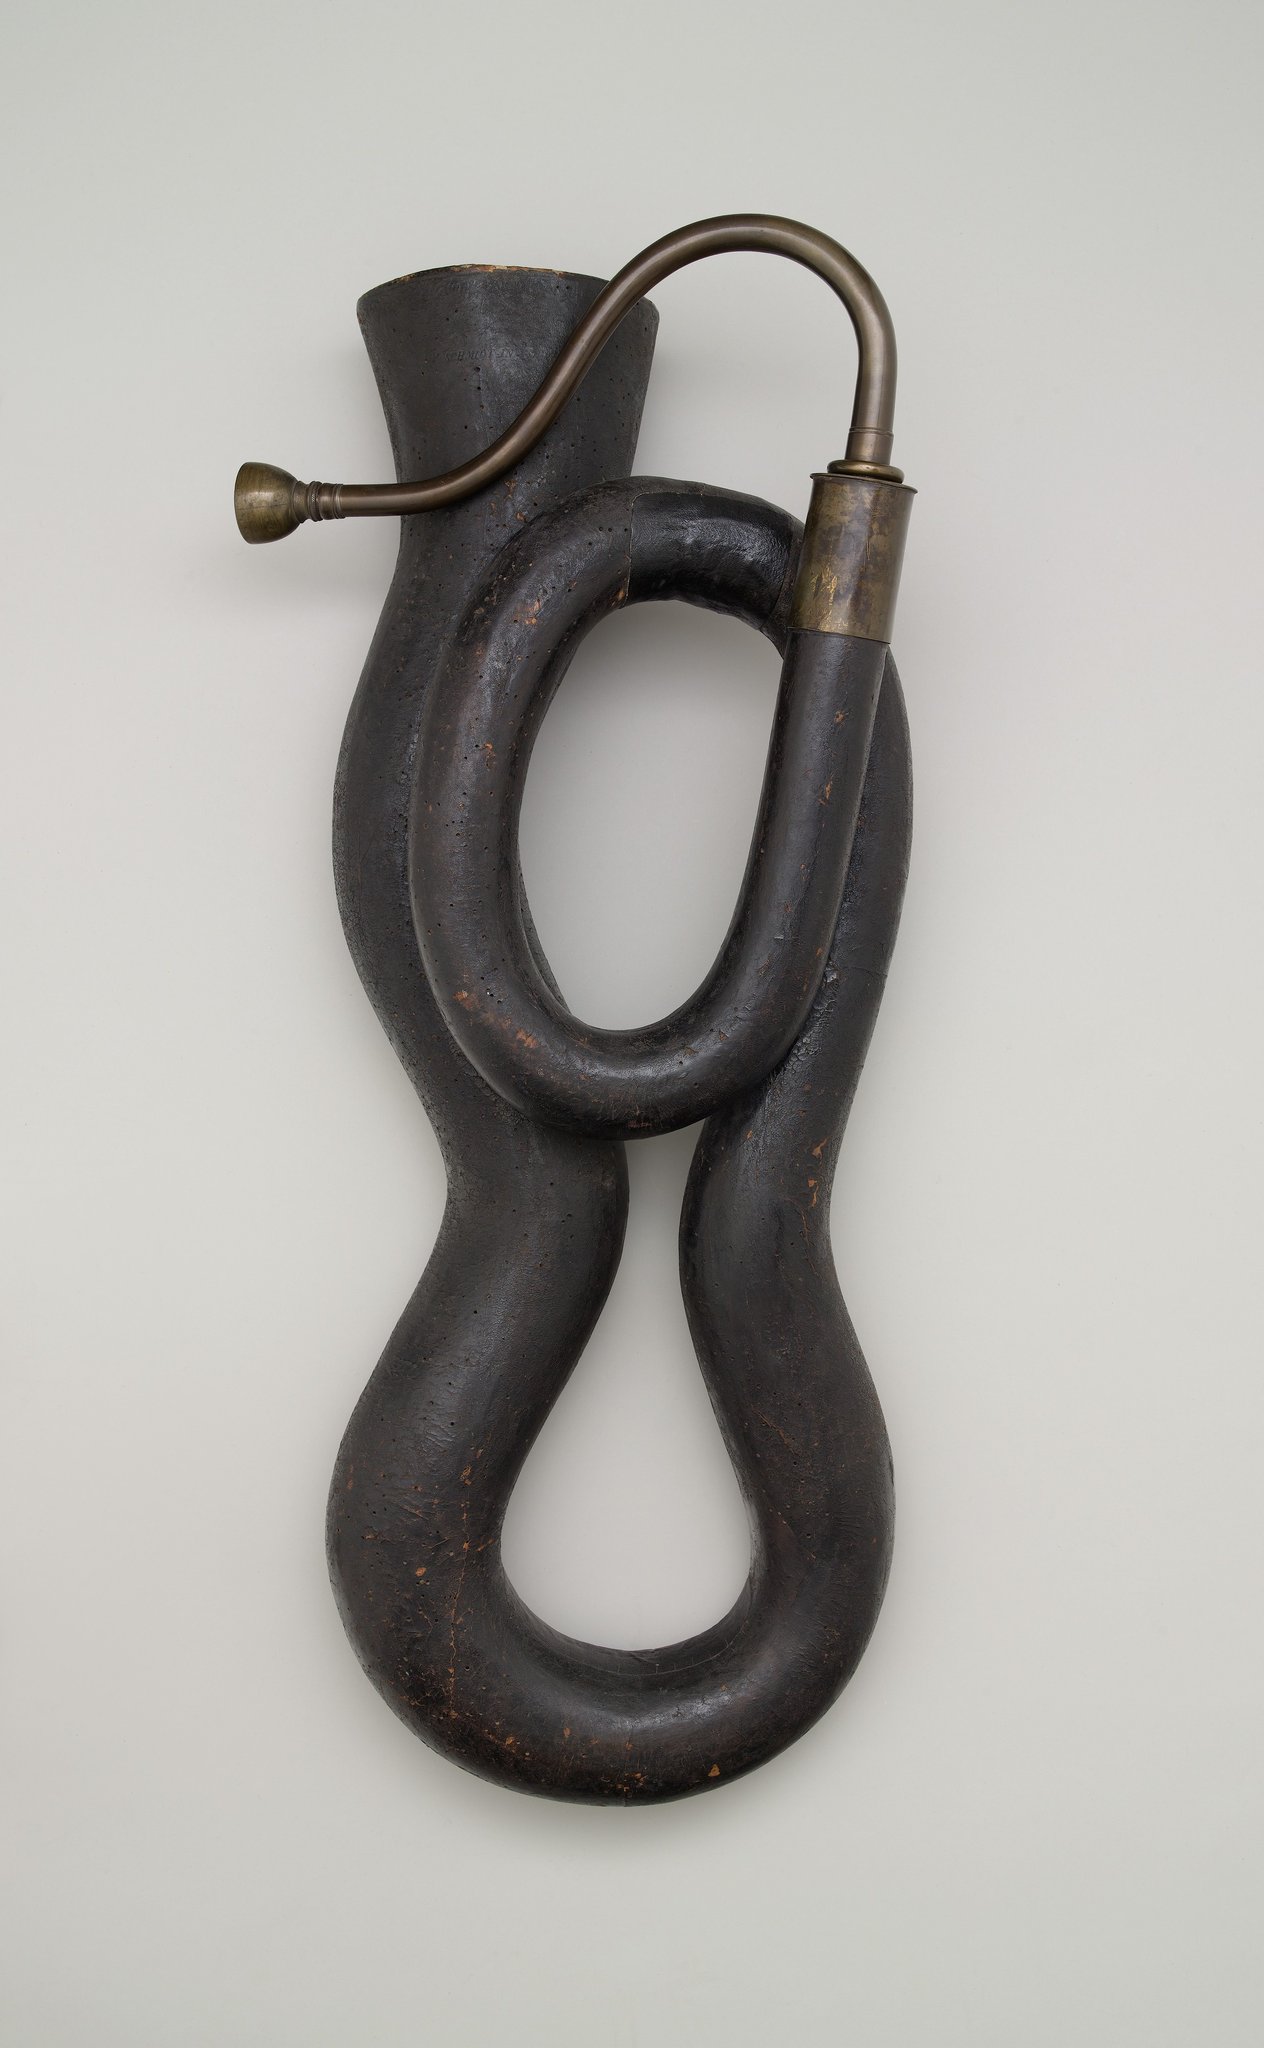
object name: serpent in c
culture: german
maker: w. schmidt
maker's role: maker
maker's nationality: german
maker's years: 1800-1900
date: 1805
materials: brass, leather, wood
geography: germany